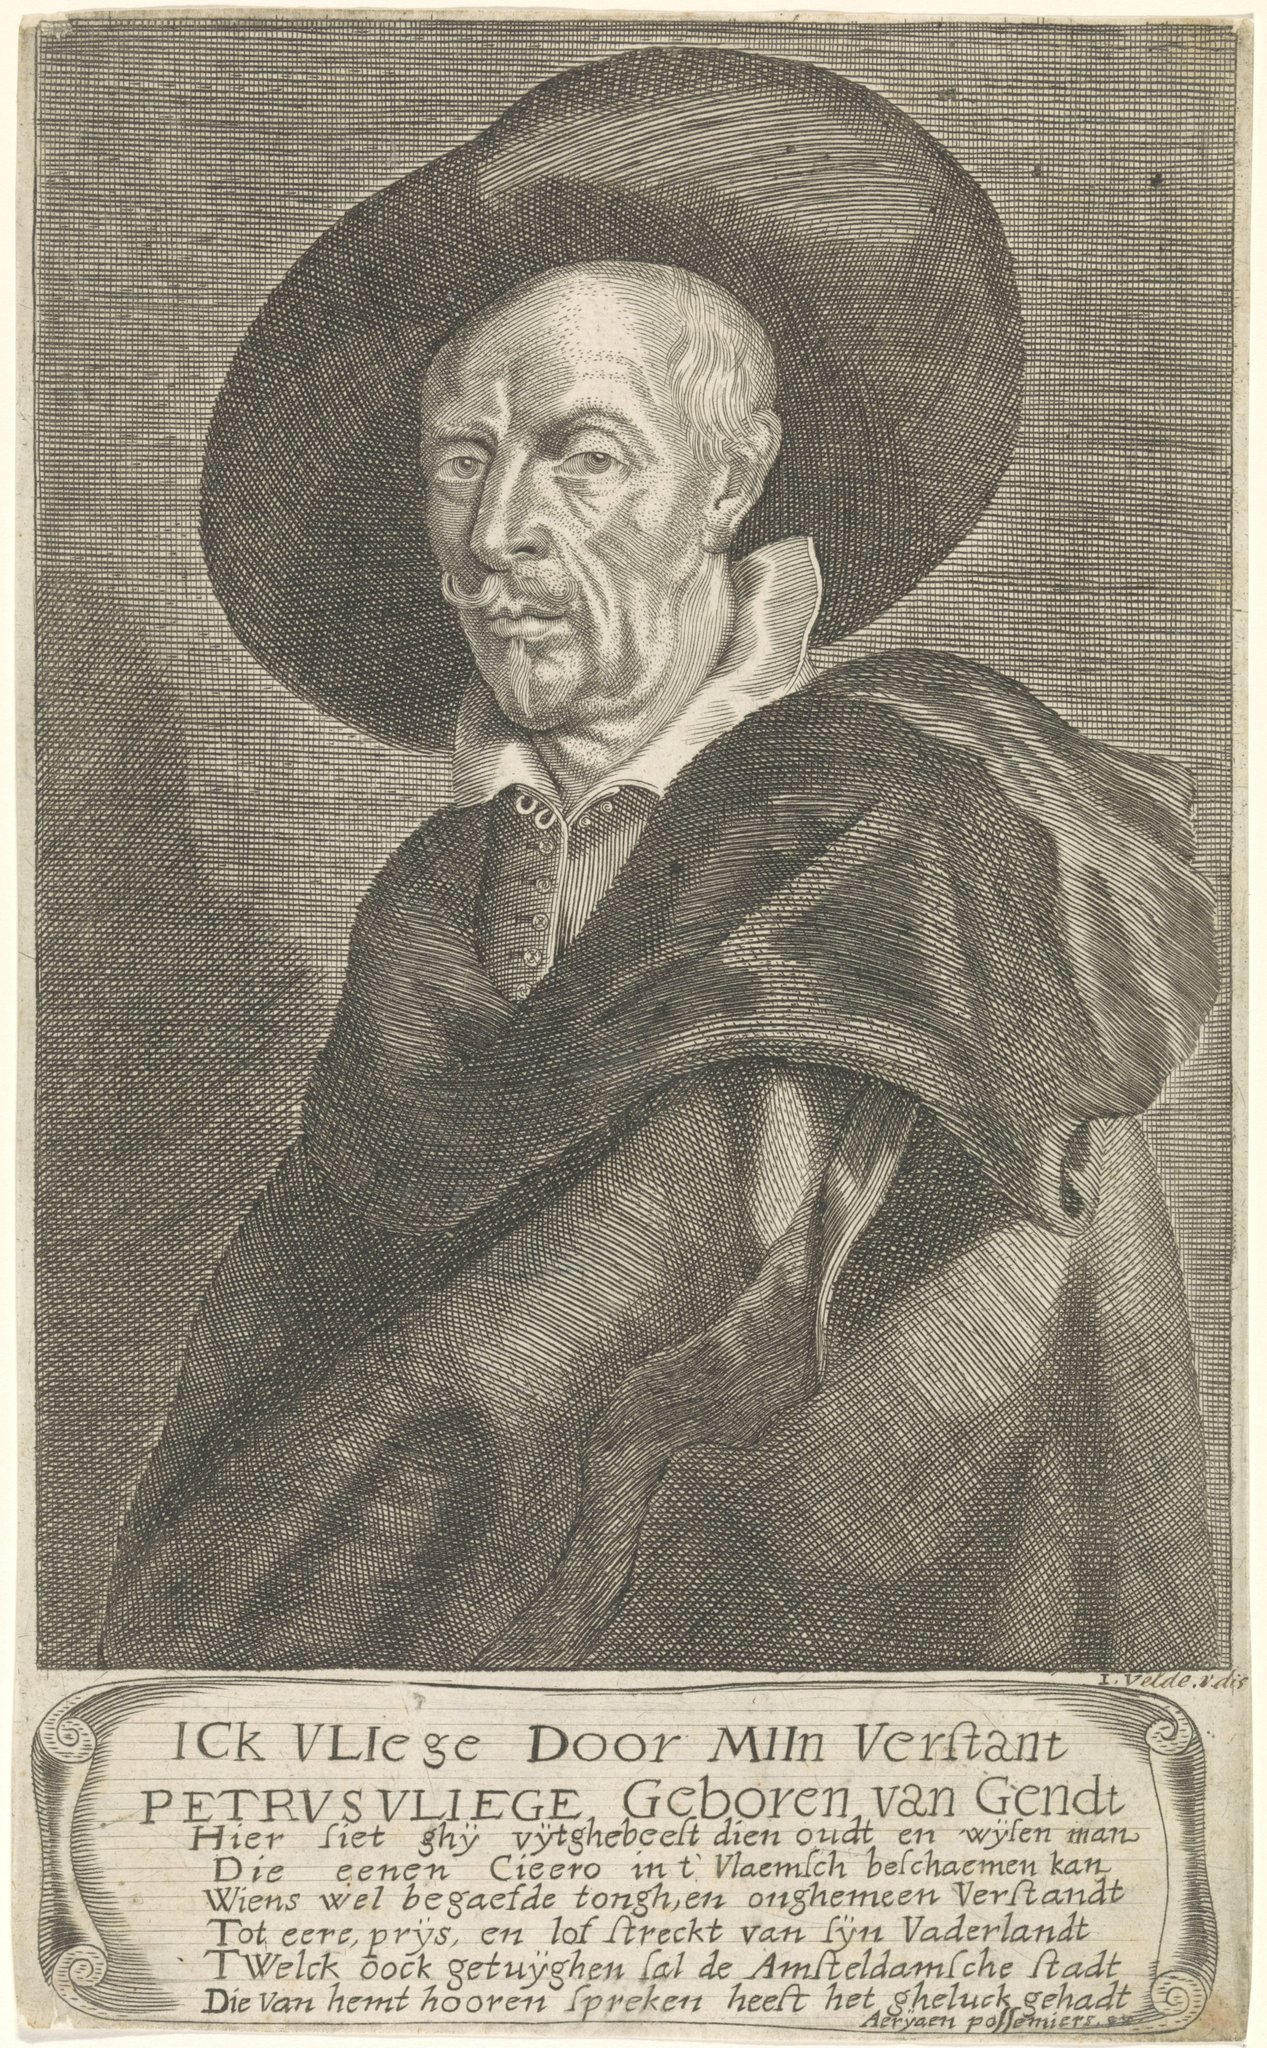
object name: print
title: Portret van de Vlaams letterkundige Petrus Vliege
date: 1662-1666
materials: paper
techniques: engraving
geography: southern netherlands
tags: ghent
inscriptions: collector's mark: Lugt 2228, name: ‘[I.V]elde v dis’